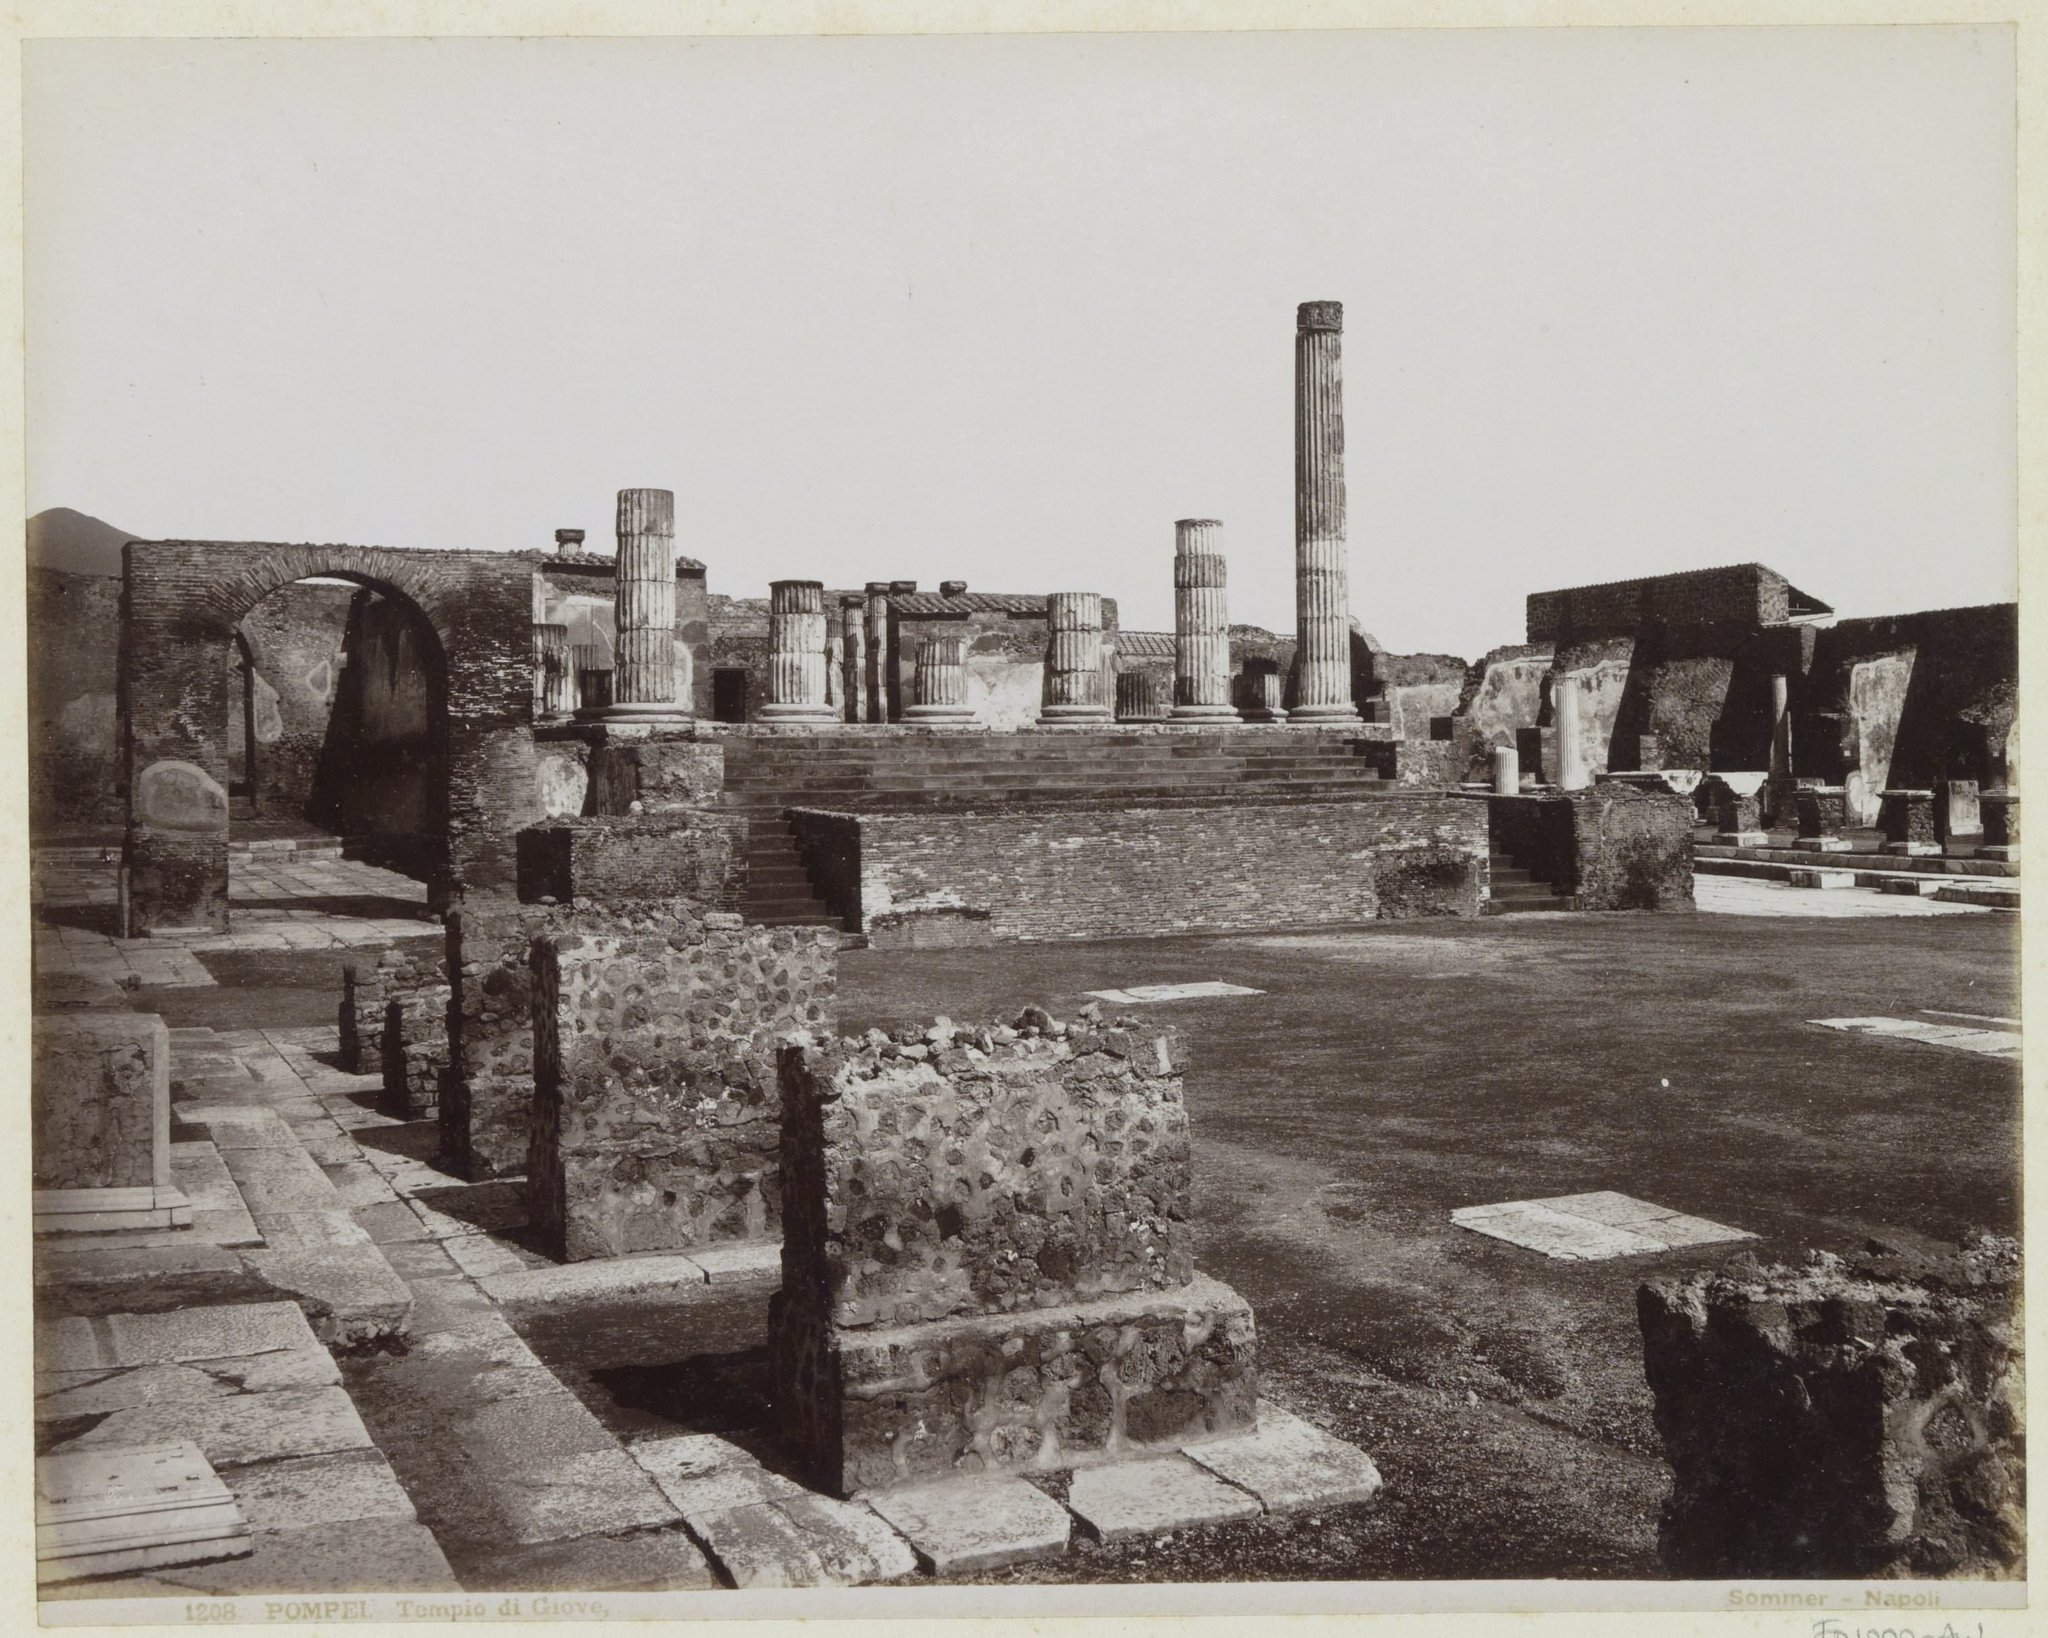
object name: photograph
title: POMPEI. Tempio di Giove.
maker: giorgio sommer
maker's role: fotograaf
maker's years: 1834-1914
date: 1870-1900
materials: paper, photographic support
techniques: albumen print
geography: pompeii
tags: temple, shrine ~ non-christian religions, excavation ~ archaeology, pompeii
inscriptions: negative number: ‘1208’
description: Onderdeel van Reisalbum met foto's van bezienswaardigheden in Italië en Frankrijk.